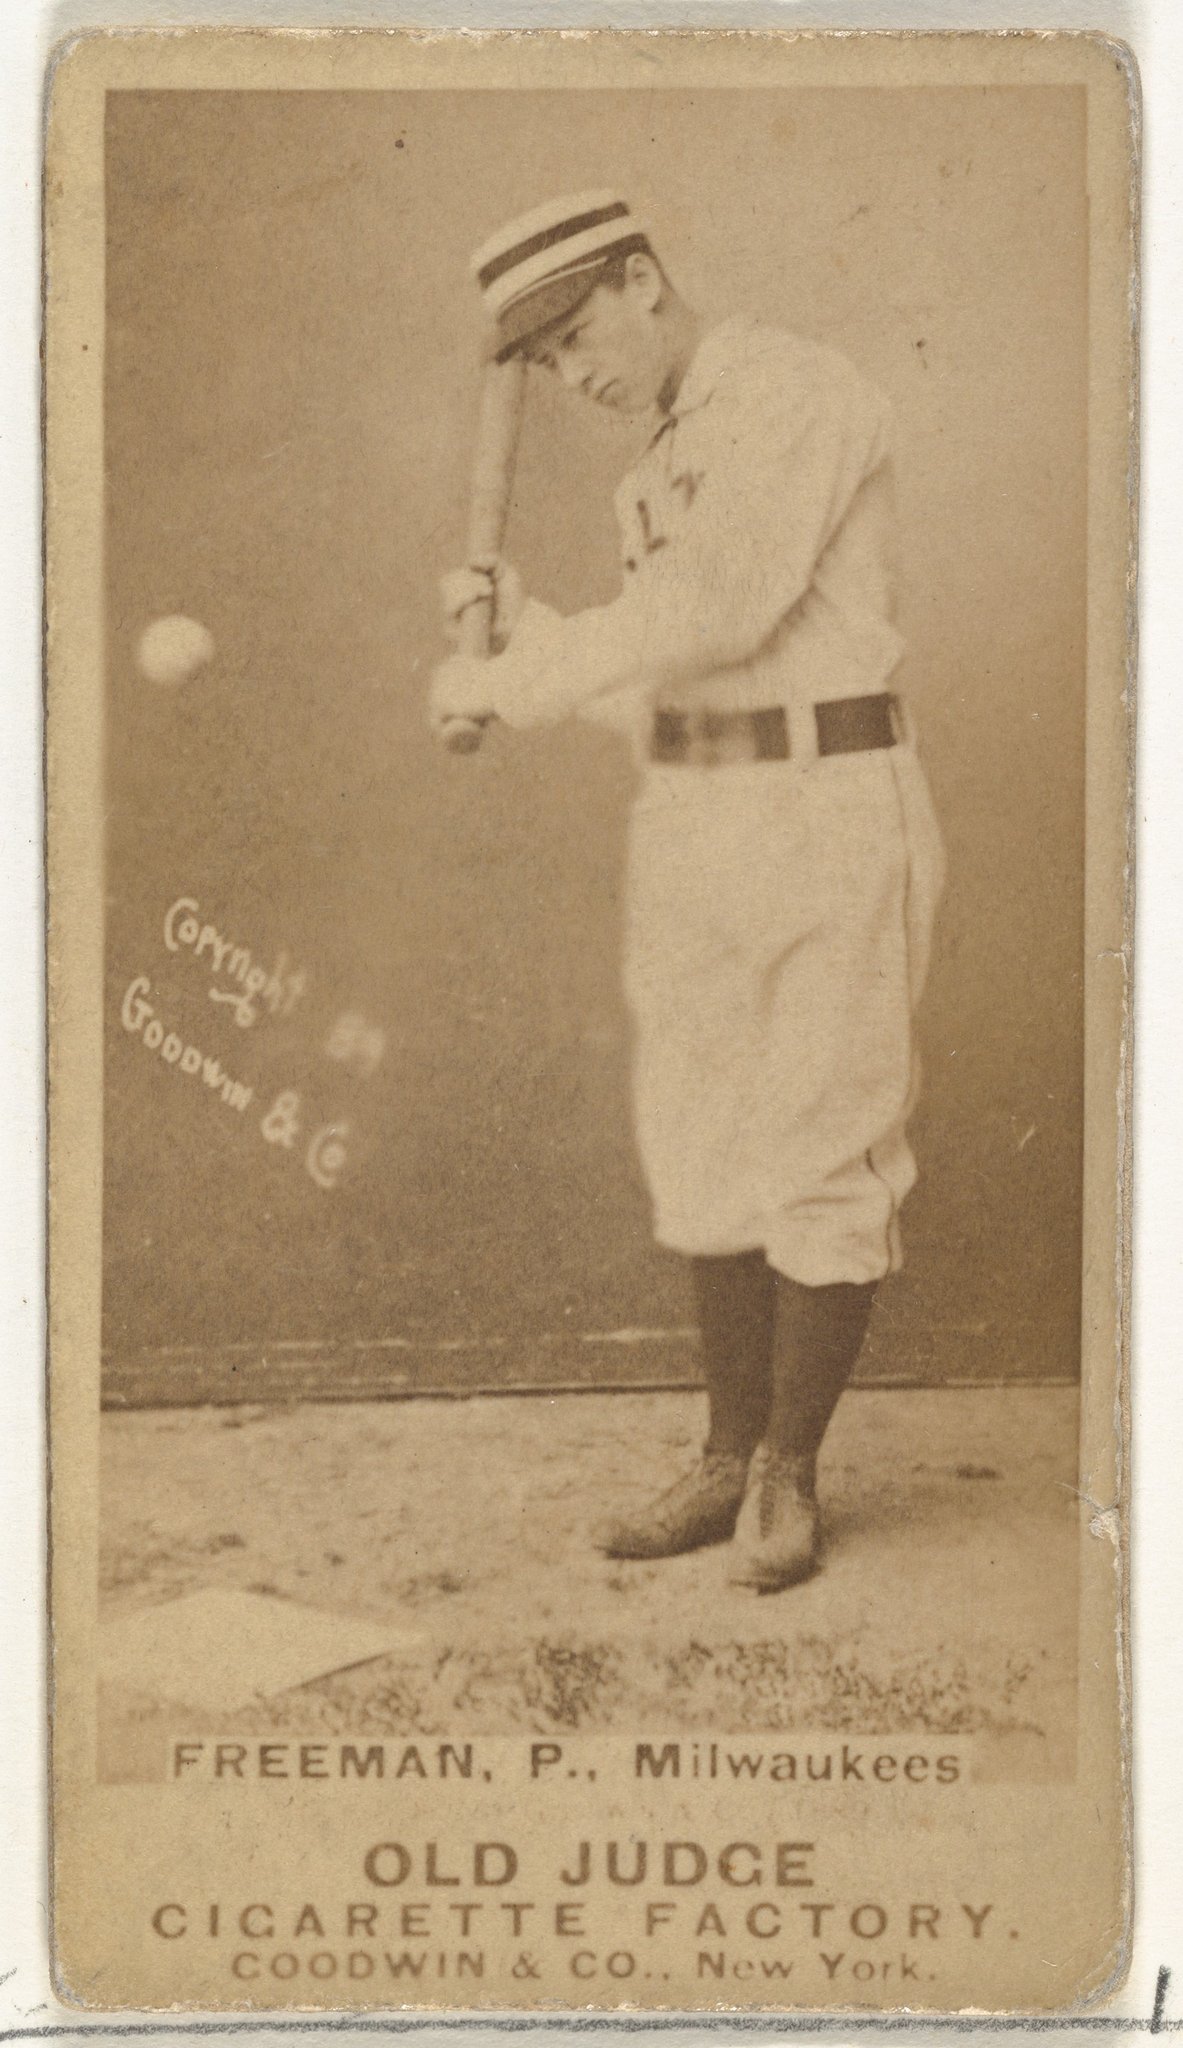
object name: baseball card, photograph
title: Julius Benjamin "Julie" Freeman, Pitcher, Milwaukee, from the Old Judge series (N172) for Old Judge Cigarettes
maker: goodwin & company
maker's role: publisher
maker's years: 1850-1950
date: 1889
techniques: albumen silver print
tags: men,portraits,baseball,athletes